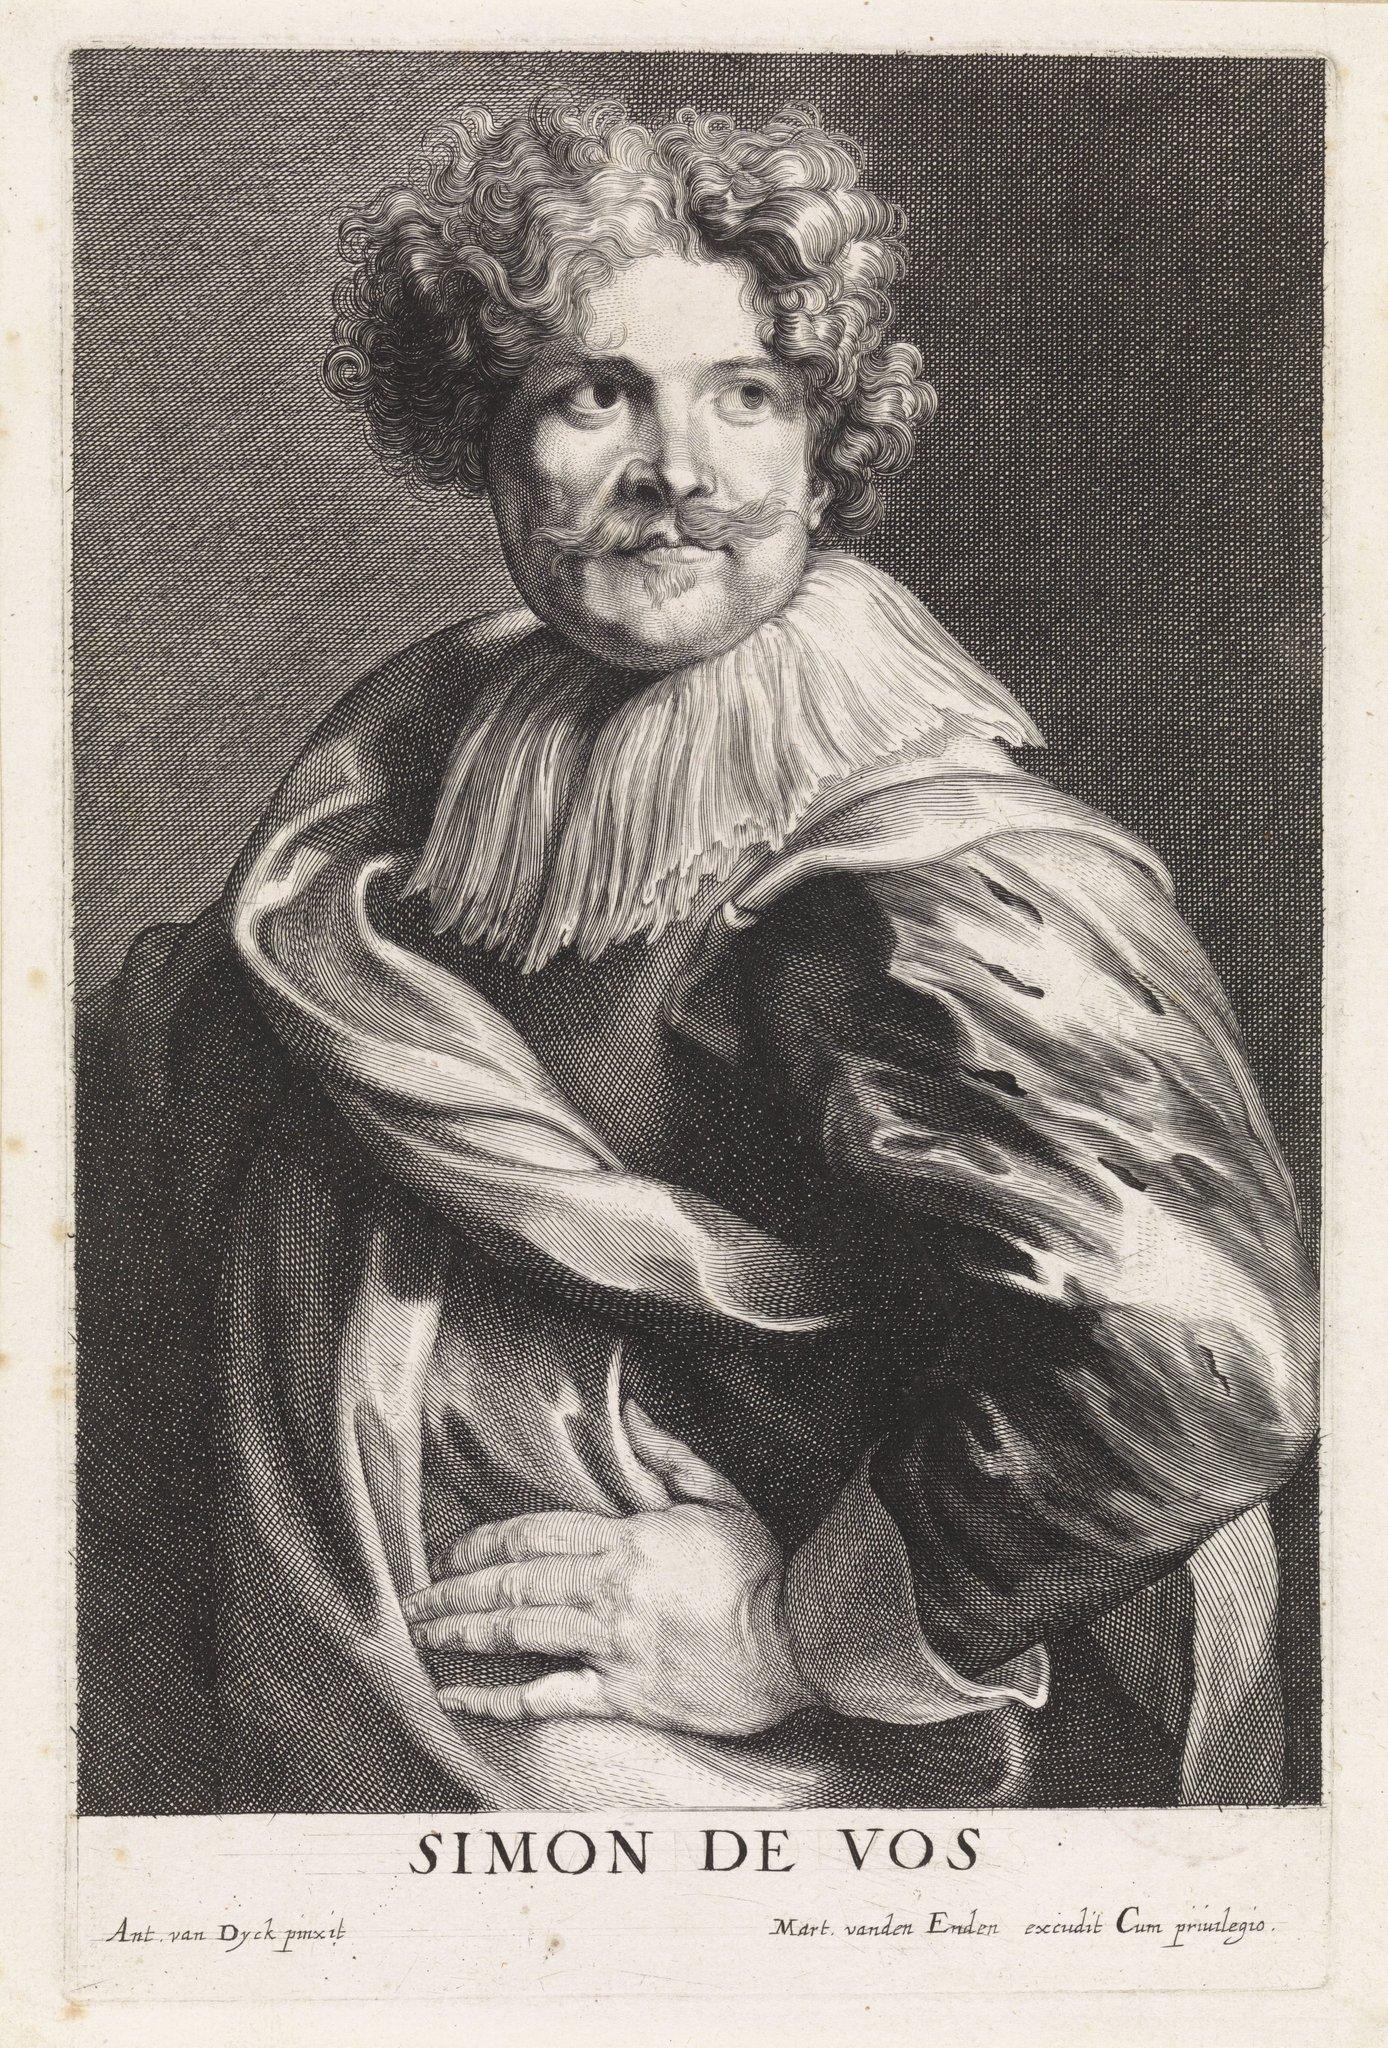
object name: print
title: Portret van de schilder Simon de Vos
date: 1616-1657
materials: paper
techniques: engraving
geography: antwerp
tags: antwerp, painter, portrait, self-portrait of painter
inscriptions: collector's mark: Lugt 240